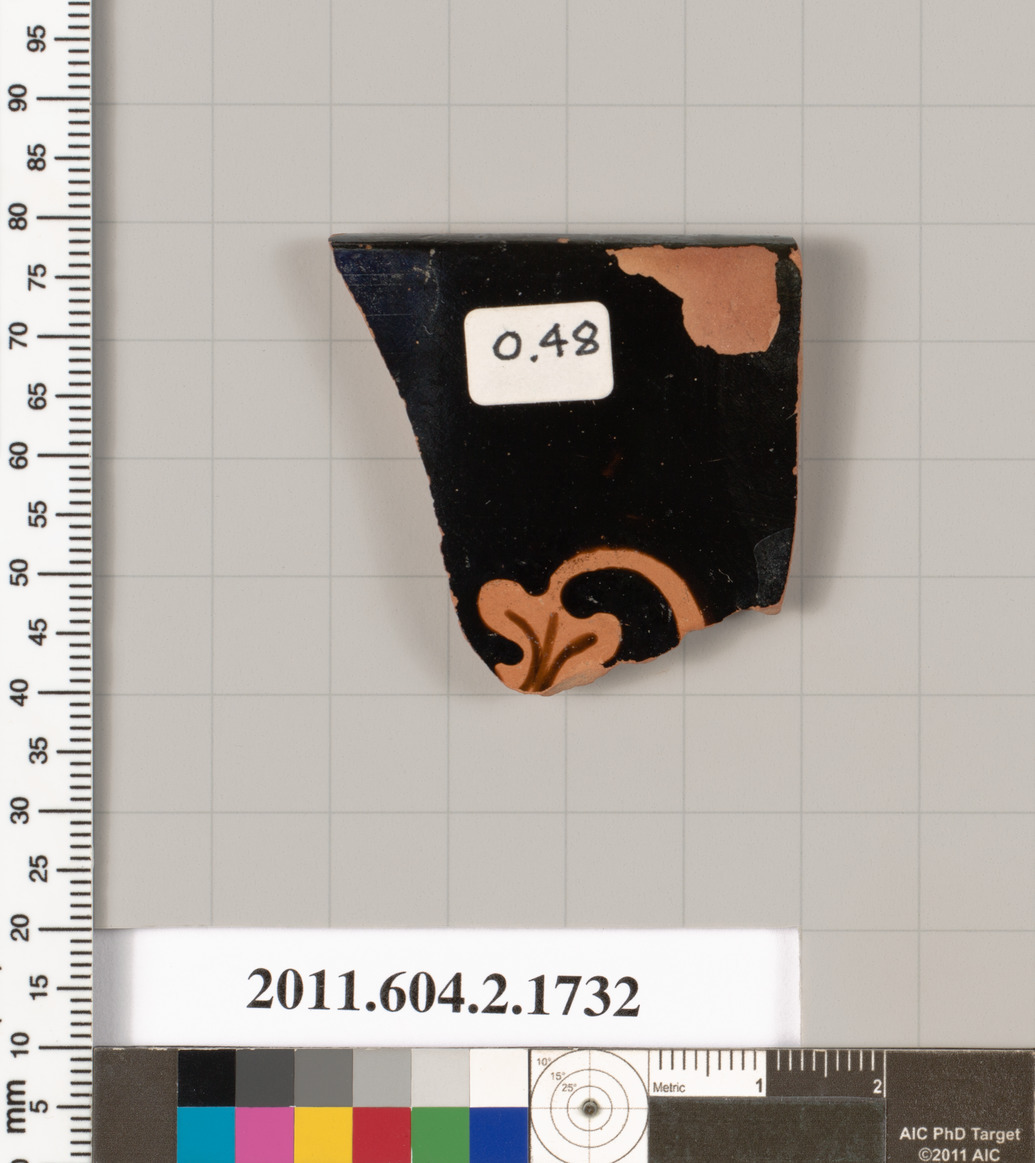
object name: skyphos fragment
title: Terracotta rim fragment of a skyphos (deep drinking cup)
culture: greek, attic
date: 475-451 BCE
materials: terracotta